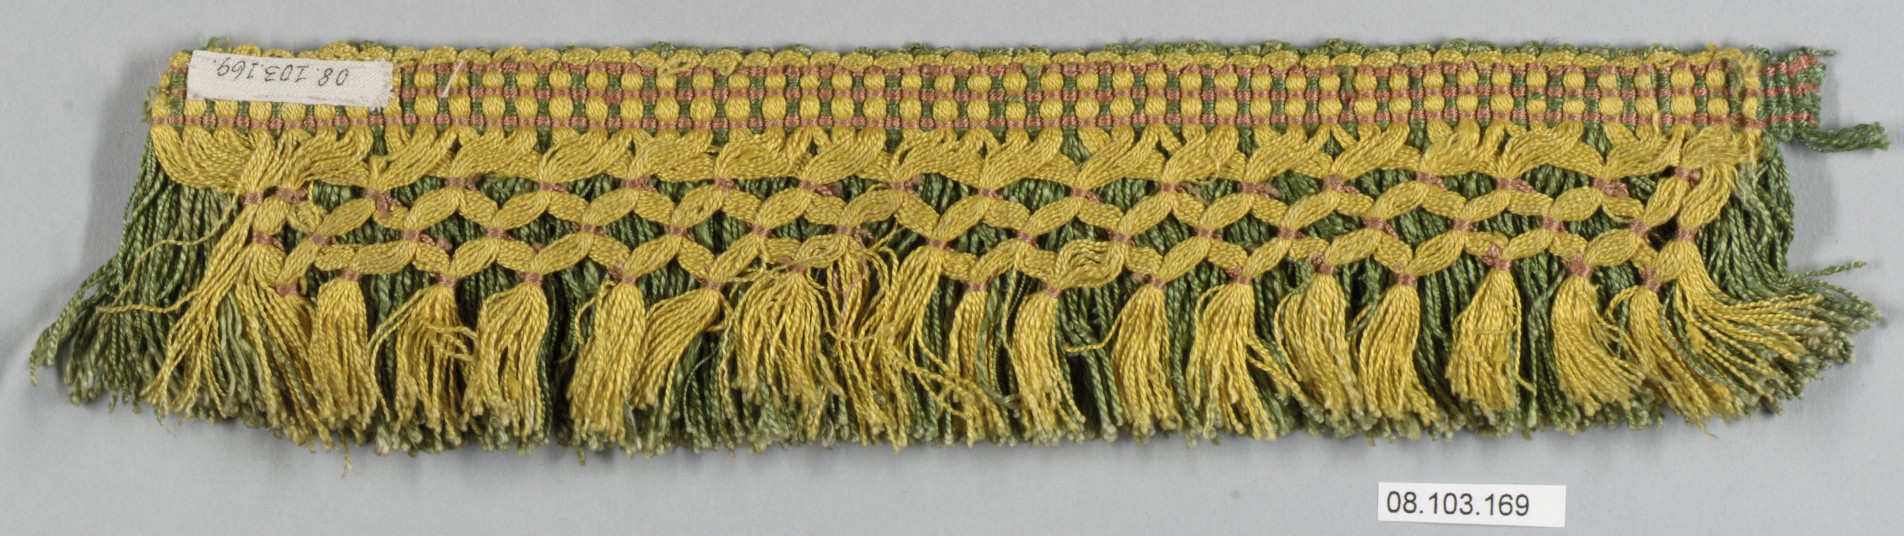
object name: fringe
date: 1601-1800